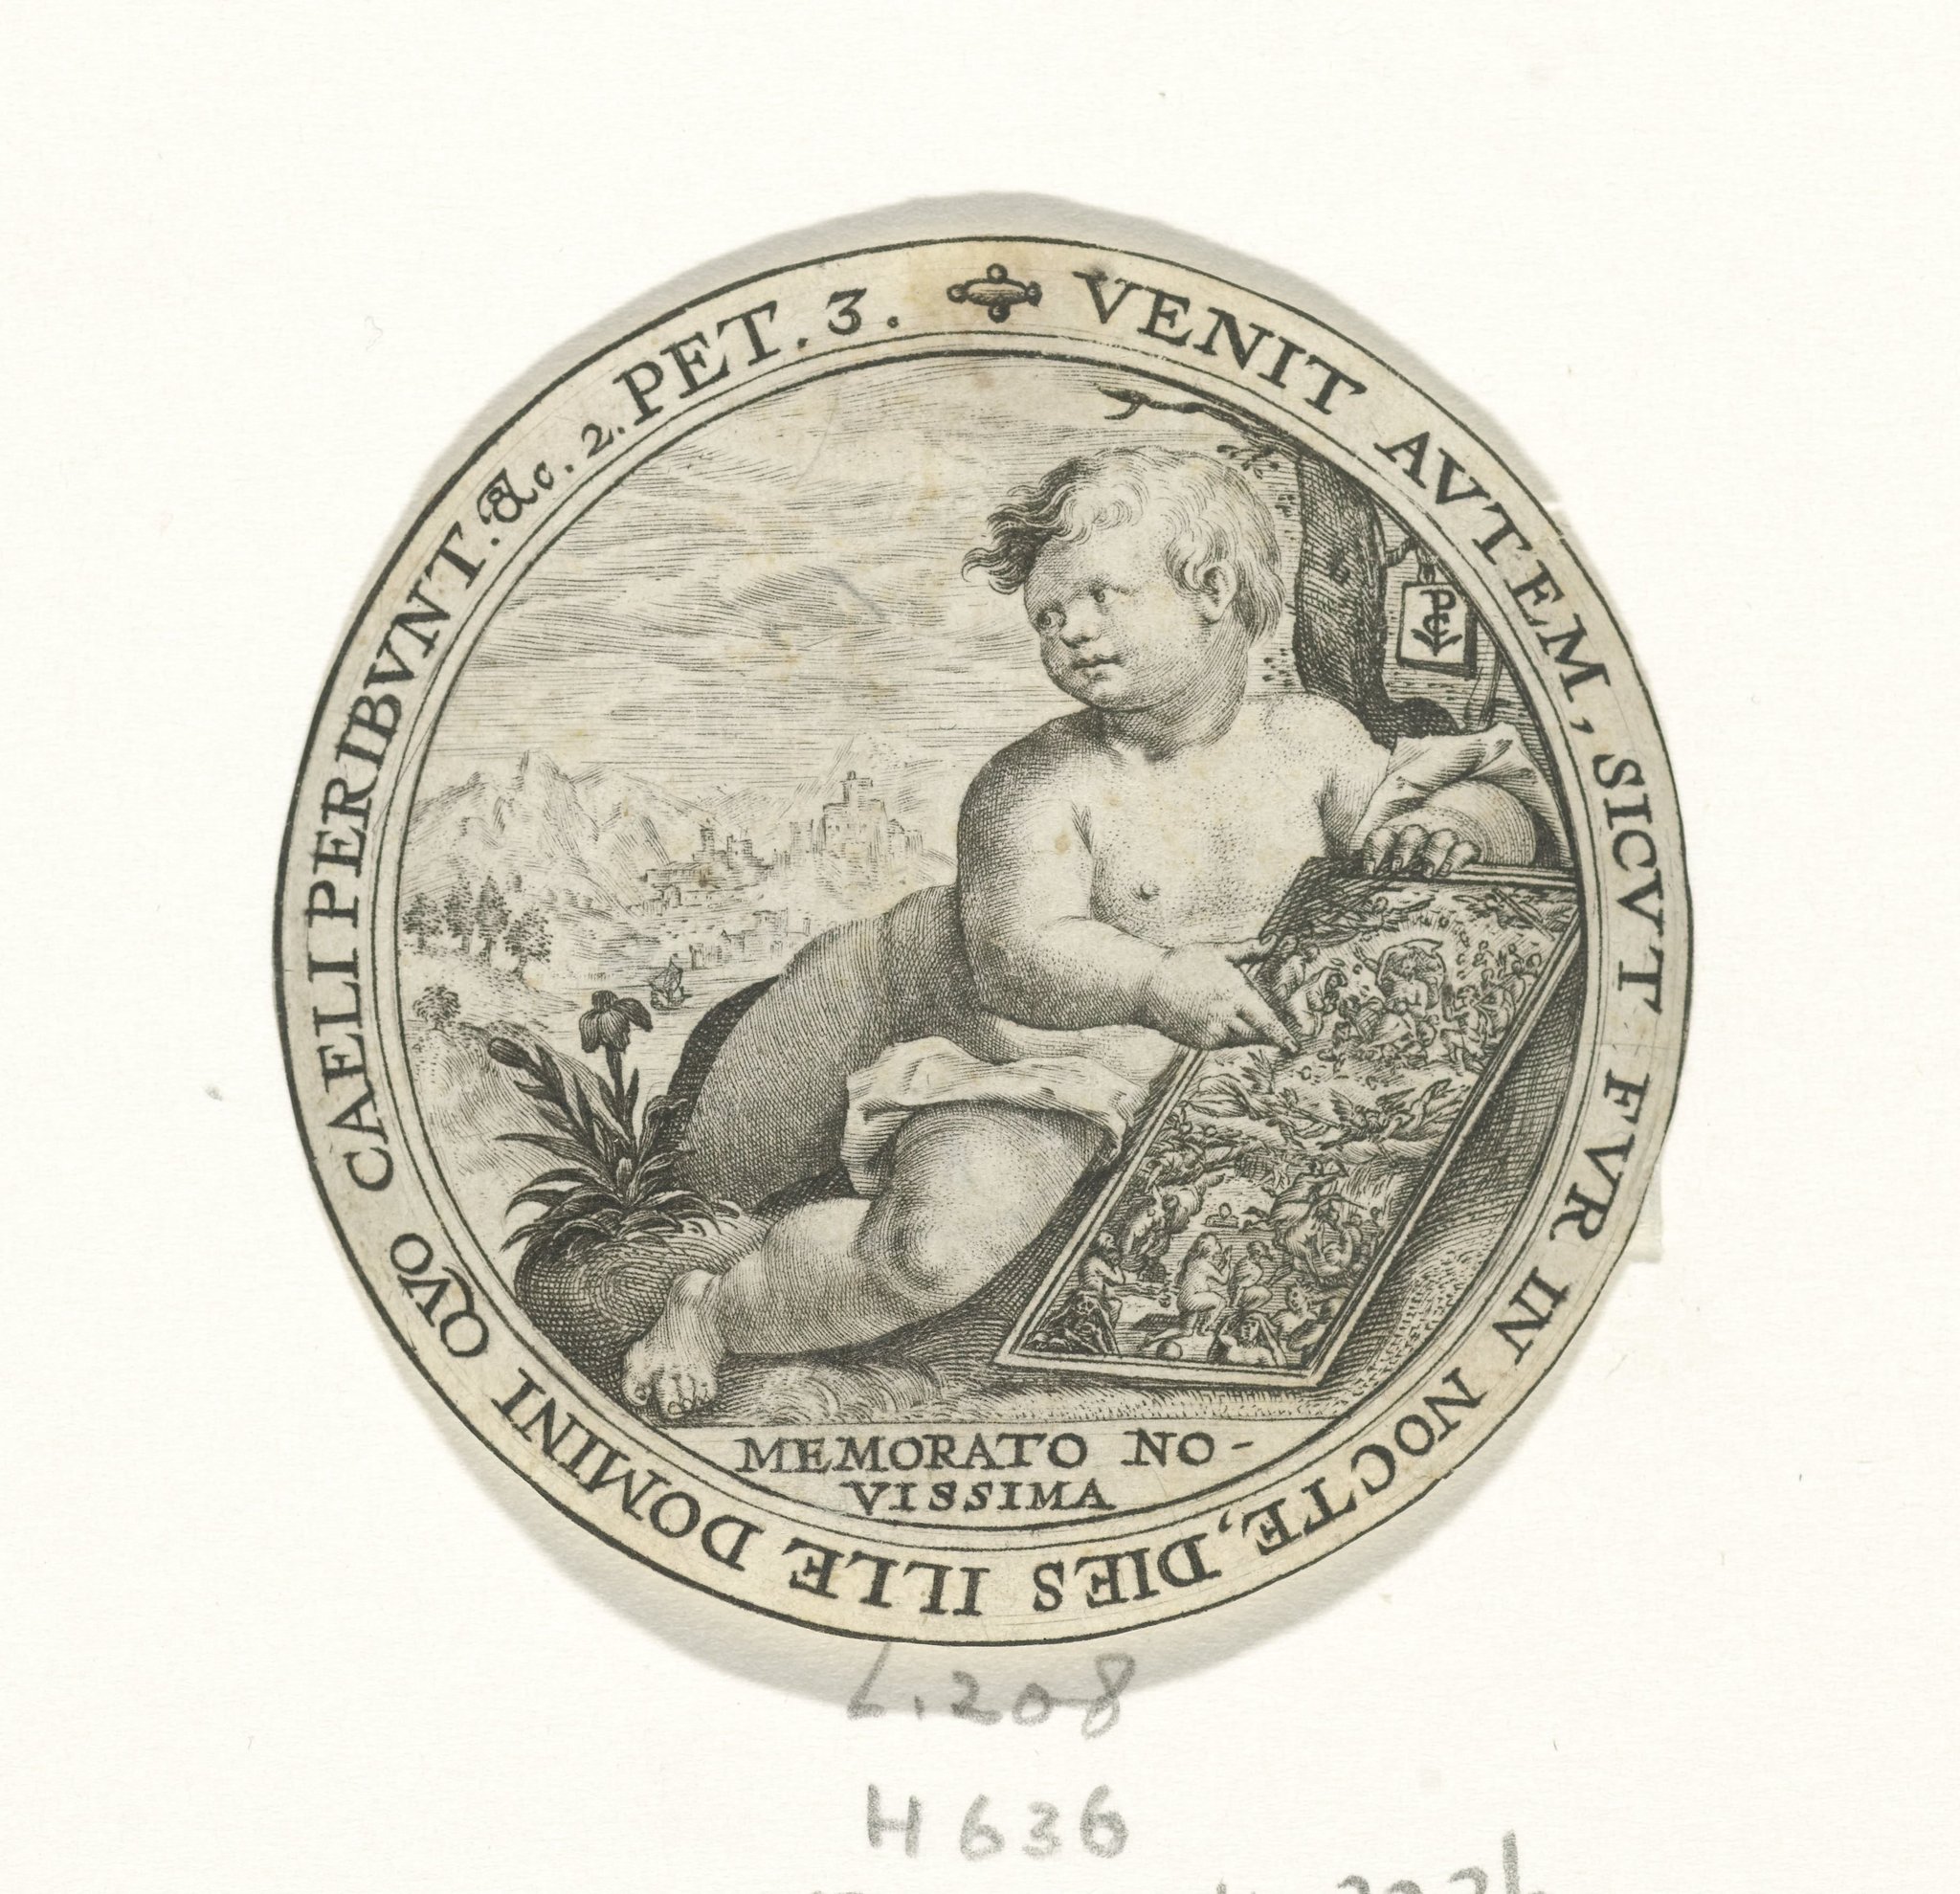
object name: print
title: Verbum Dei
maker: crispijn van de passe (i)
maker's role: draughtsman, print maker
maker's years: 1564-1637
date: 1594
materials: paper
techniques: engraving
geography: cologne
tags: last judgement, angel(s) represented as child(ren)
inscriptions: collector's mark: Lugt 2228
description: Medaillon met een putto die een tablet vasthoudt met het Laatste Oordeel. De prent heeft een omlijsting met een Bijbelcitaat uit 2 Petr. 3 in het Latijn.